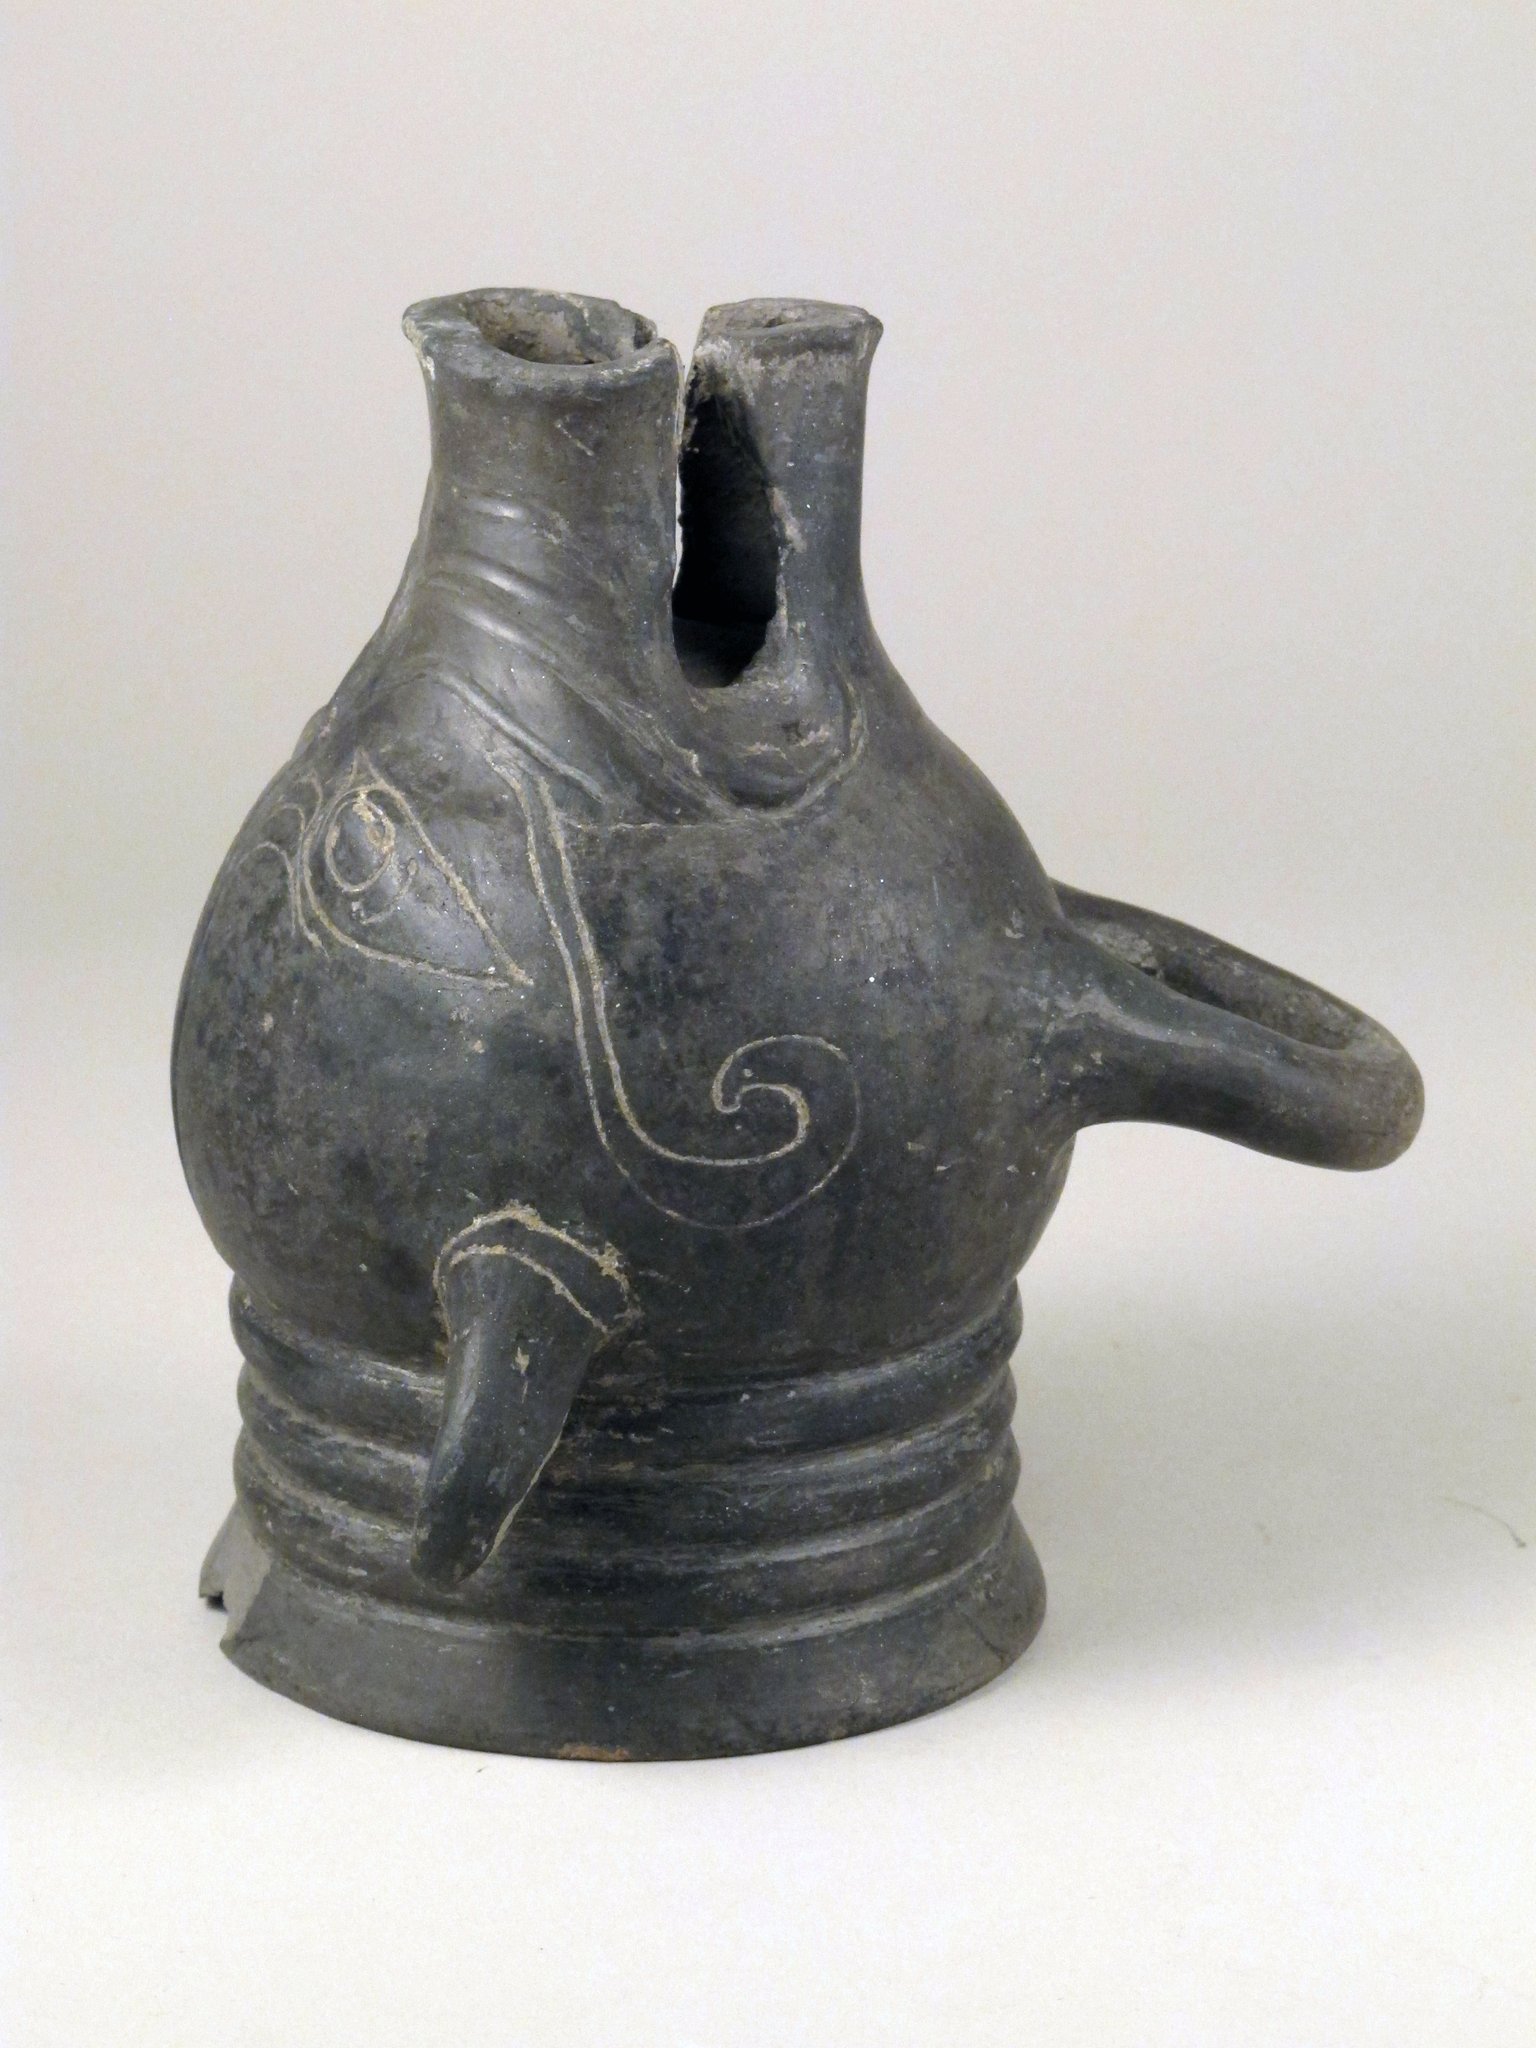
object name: cup in the form of a head of a pig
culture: etruscan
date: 900-100 BCE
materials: terracotta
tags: pigs